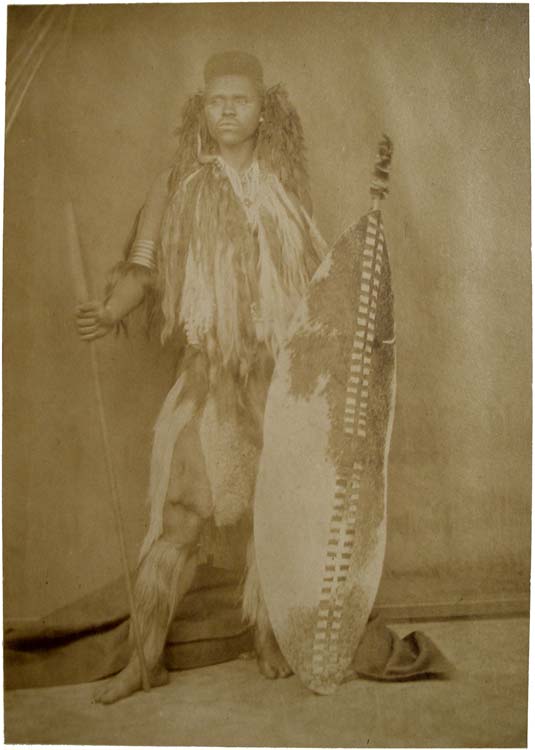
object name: photograph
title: Zulu Warrior with Ox-hide Shield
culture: african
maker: nicolaas henneman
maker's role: artist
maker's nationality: dutch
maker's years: 1813-1898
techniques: albumen print, glass negative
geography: south africa